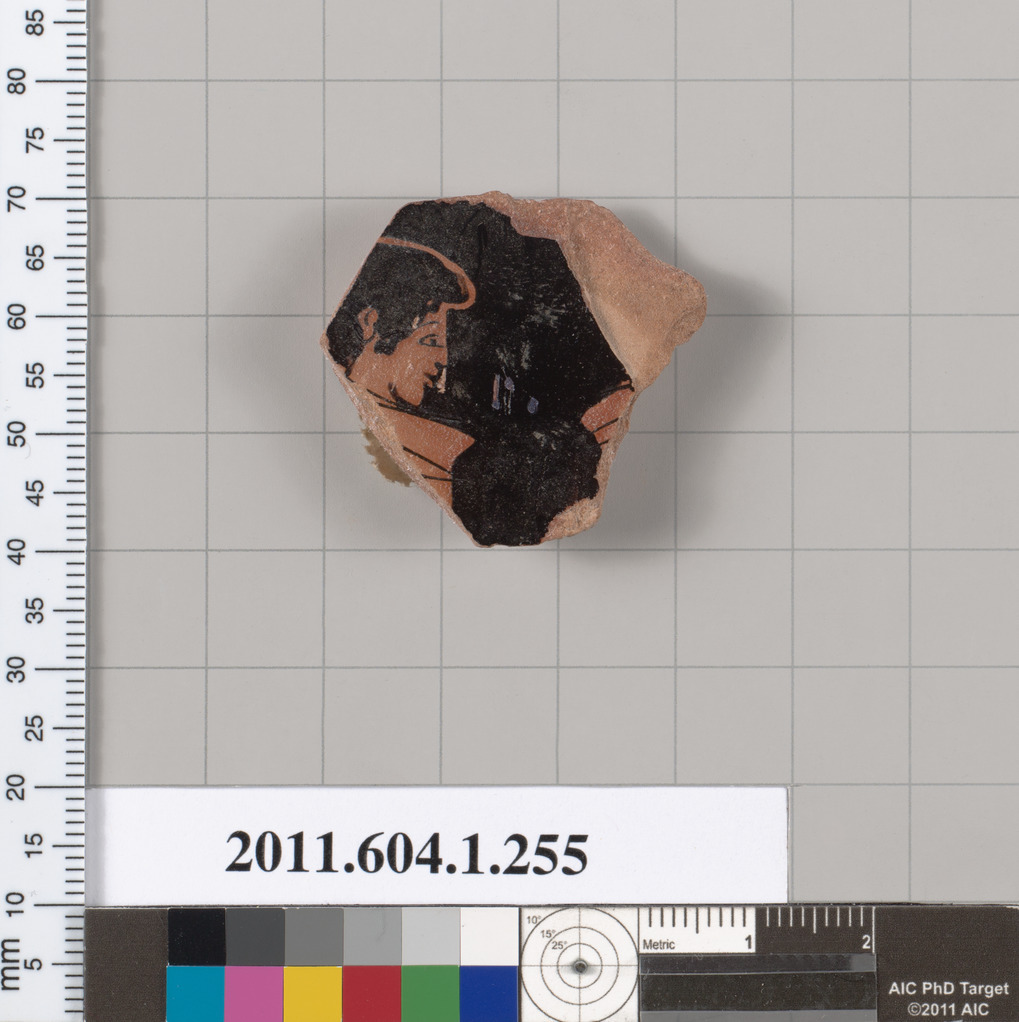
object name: kylix fragment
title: Terracotta fragment of a kylix (drinking cup)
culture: greek, attic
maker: penthesilean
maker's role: artist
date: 470-450 BCE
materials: terracotta